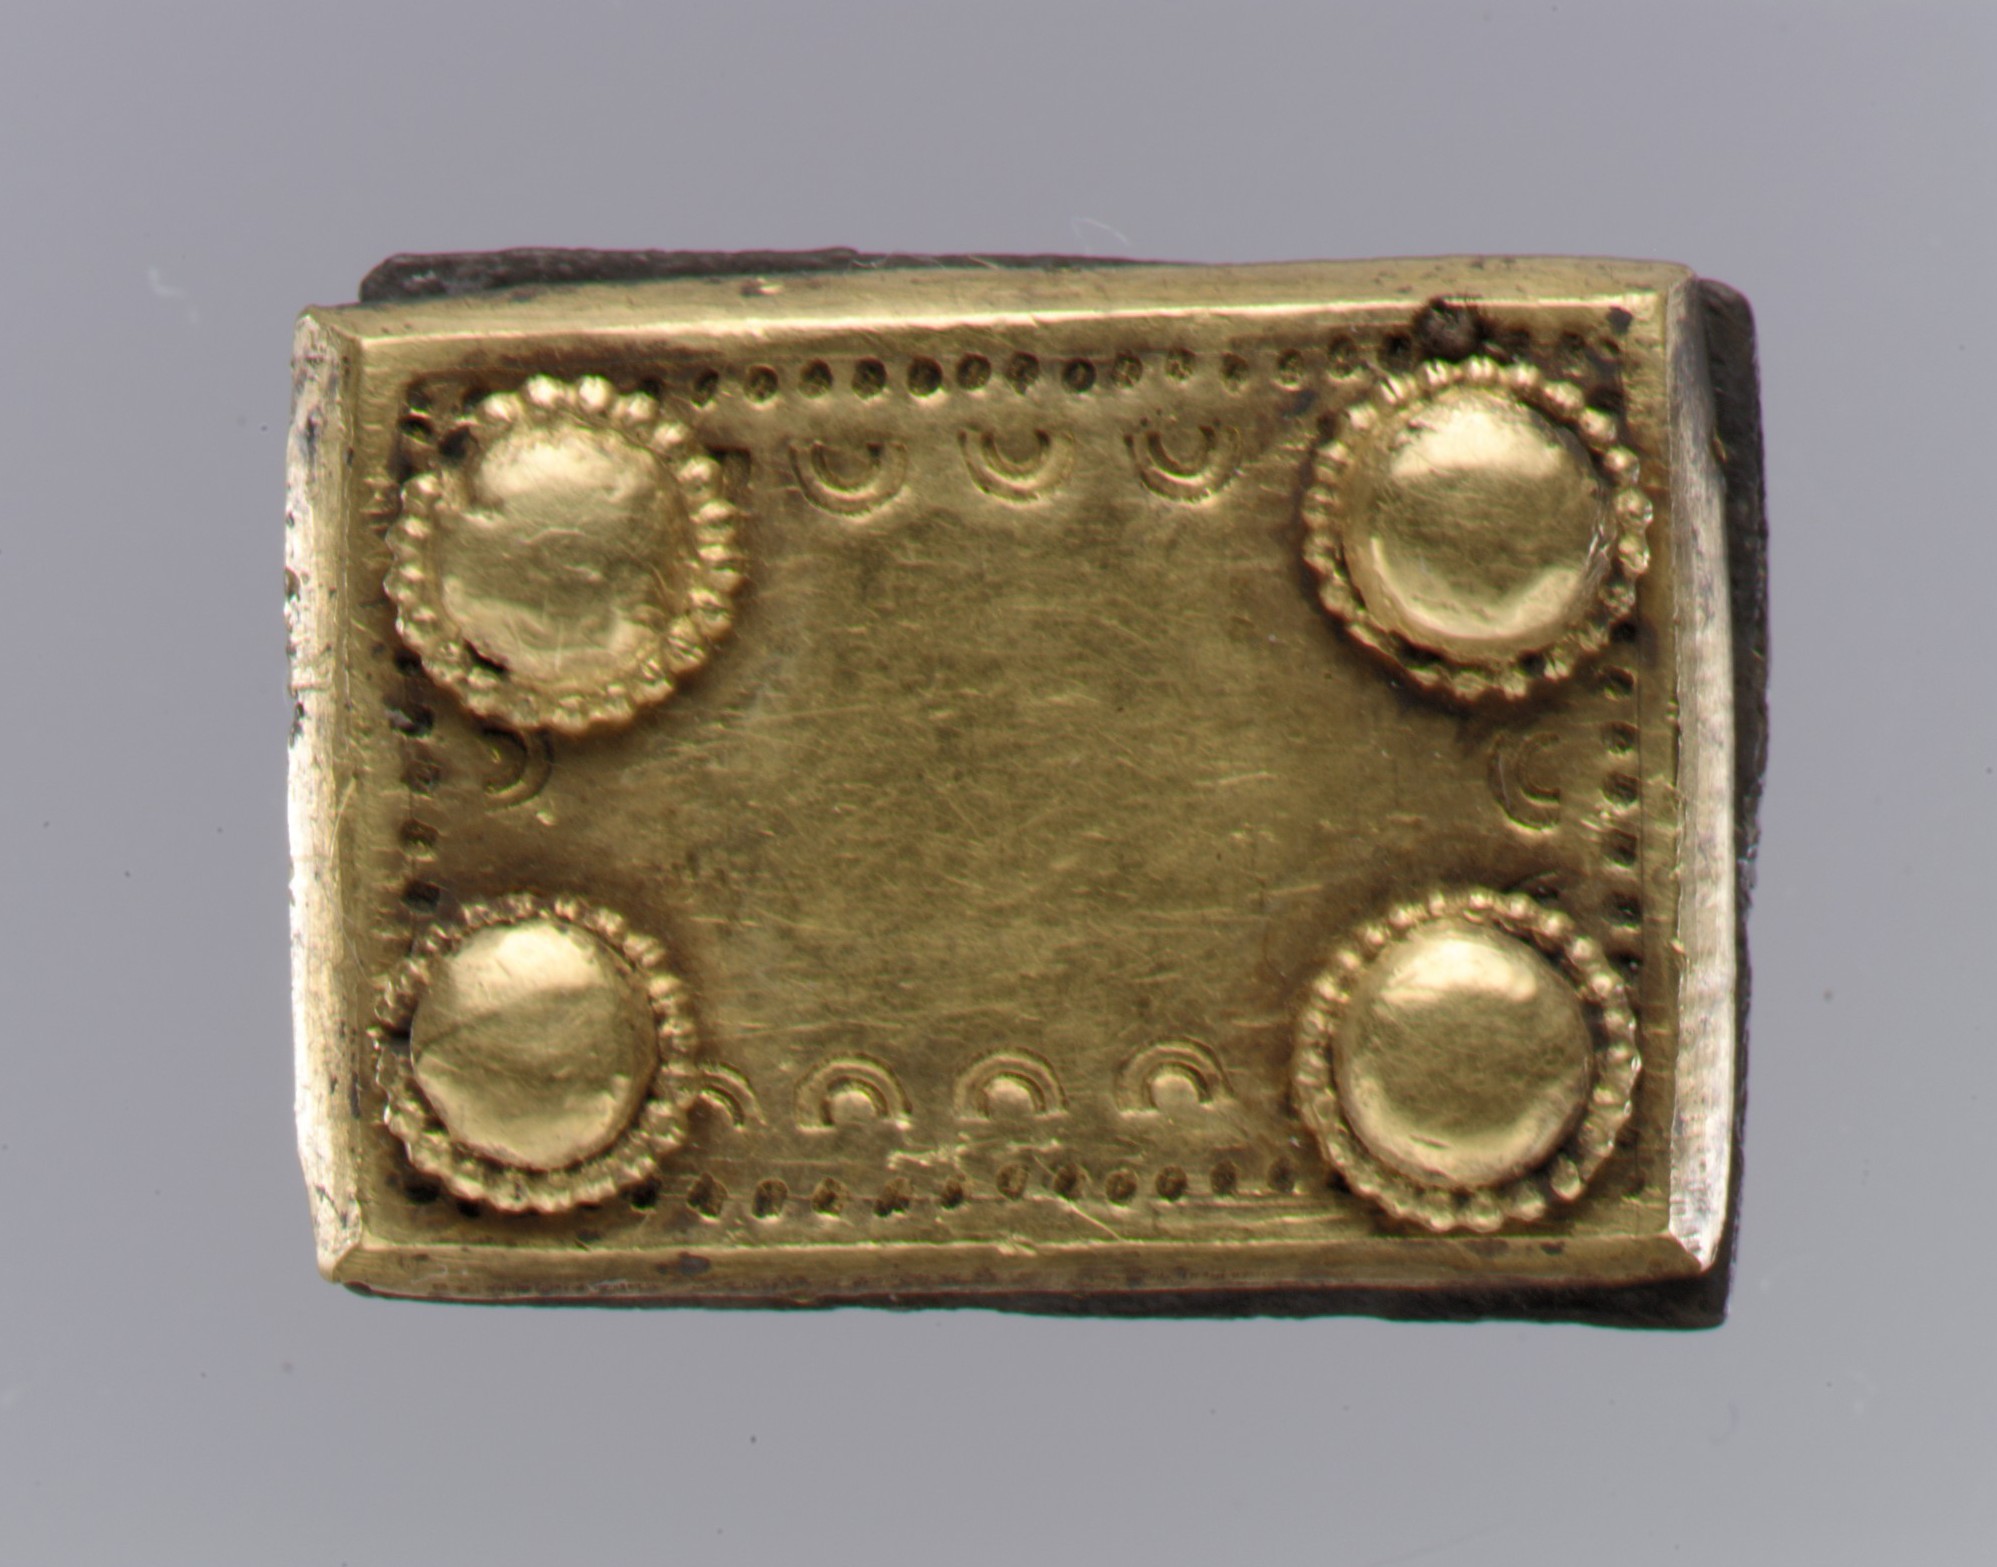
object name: belt plate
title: Gold Back Plate of Belt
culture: langobardic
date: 600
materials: gold, silver